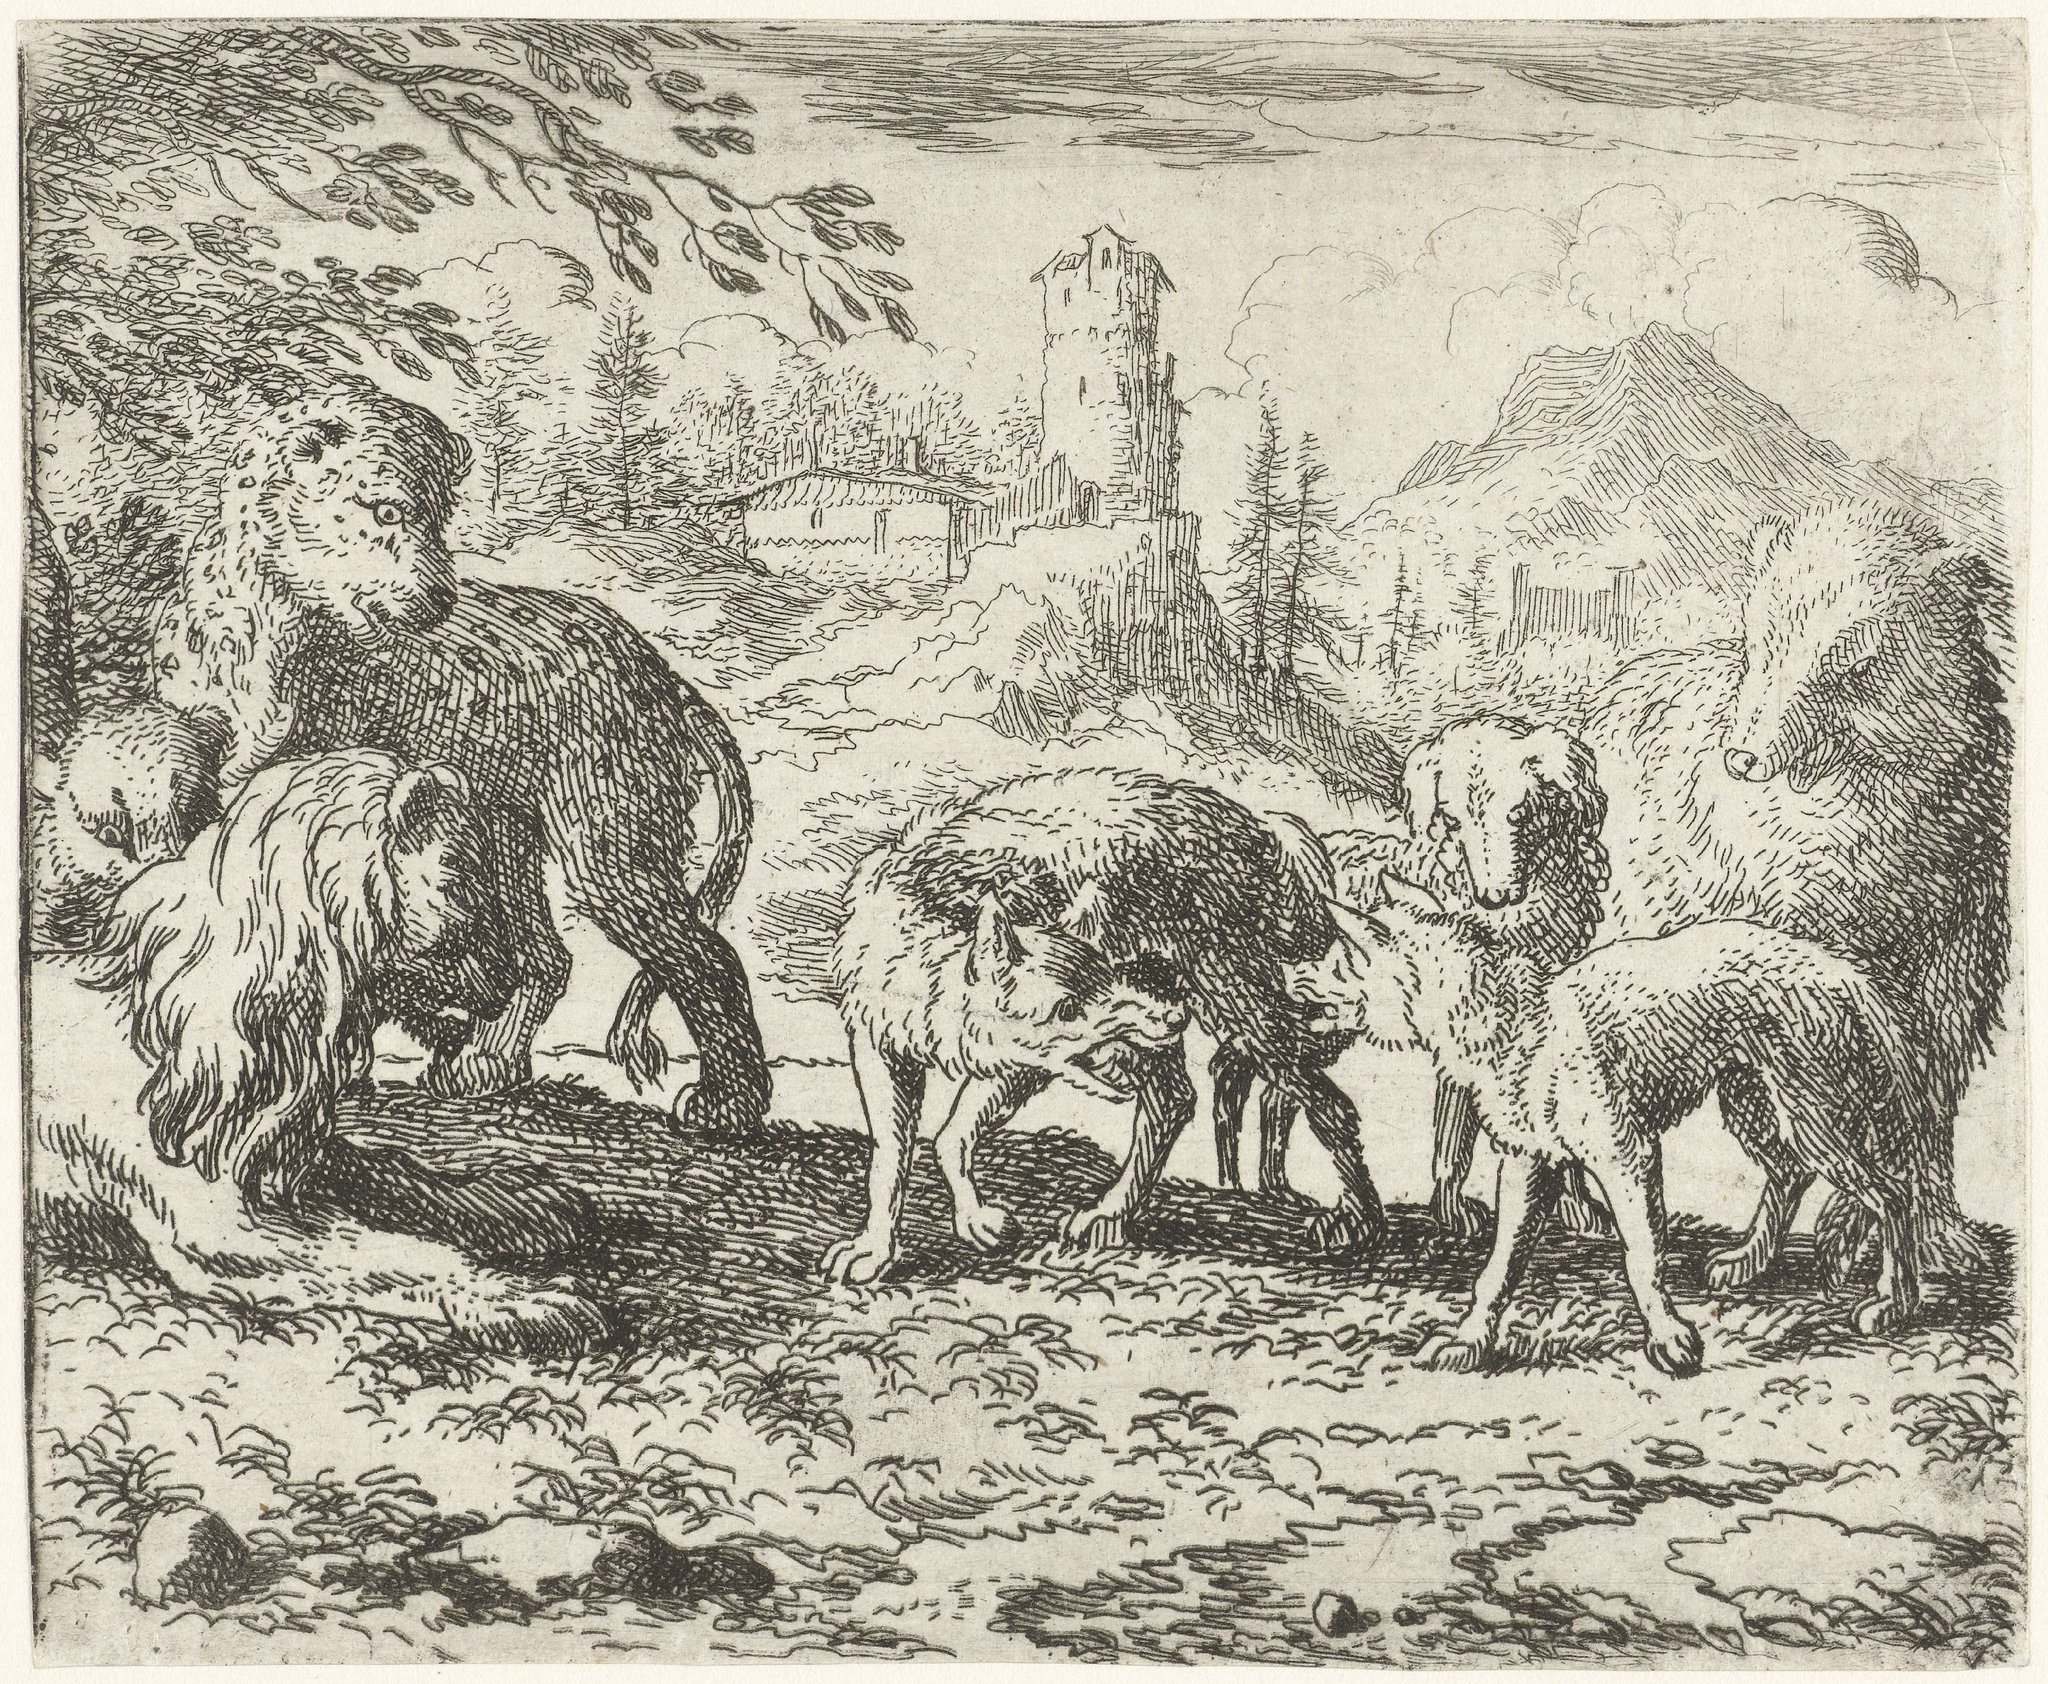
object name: print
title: Reinaert de vos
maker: allaert van everdingen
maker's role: draughtsman, painter, print maker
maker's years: 1621-1675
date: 1665-1675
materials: paper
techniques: etching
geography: netherlands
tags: fable of reynard the fox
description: Isengrijn de wolf en Reinaert de vos staan met de koppen tegenover elkaar in het bijzijn van andere dieren, waaronder Bruun de beer en de leeuw koning Nobel. Op de achtergrond een berglandschap met een toren.